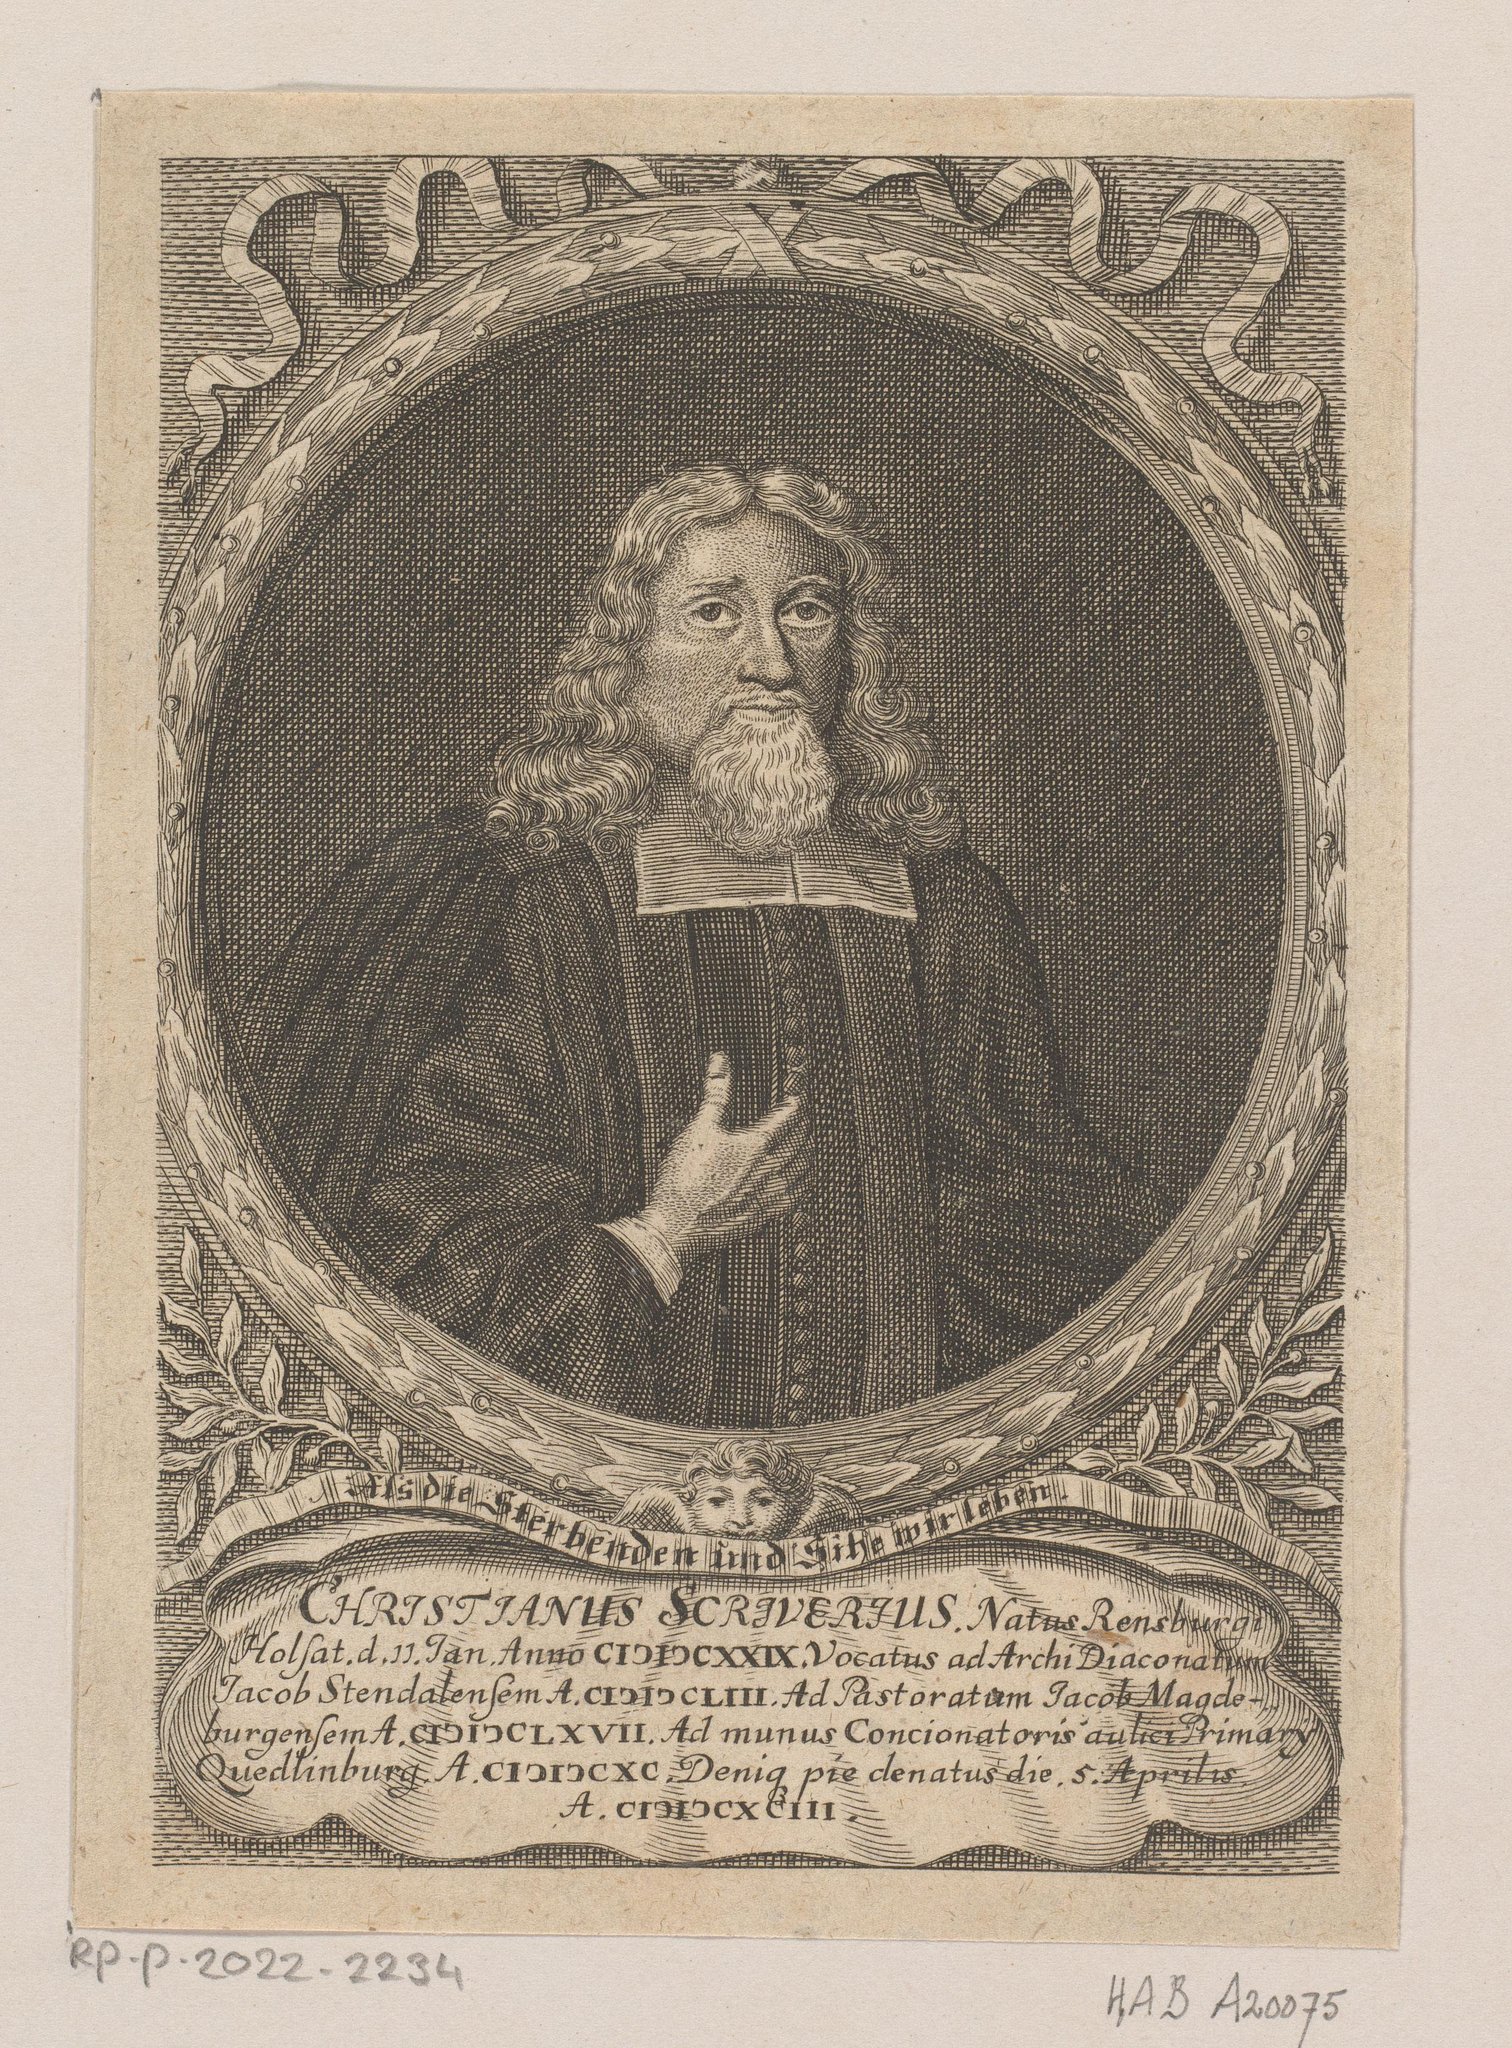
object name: print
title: Portret van Christian Scriver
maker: Anonymous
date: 1693-1750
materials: paper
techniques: engraving, etching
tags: theologian, historical persons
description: Met een regel in het Duits en een zesregelig onderschrift in het Latijn.